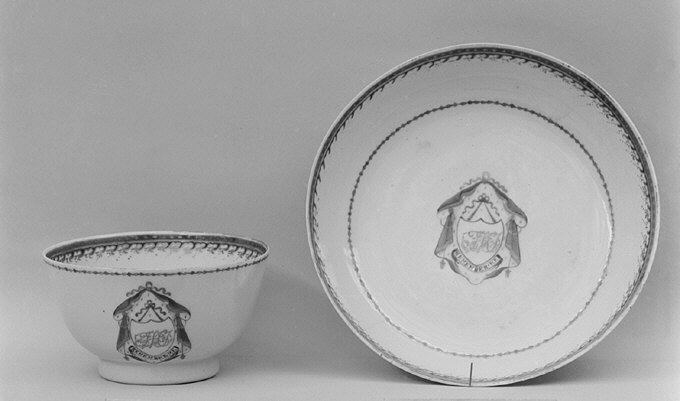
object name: cup and saucer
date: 1790-1800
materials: hard paste porcelain